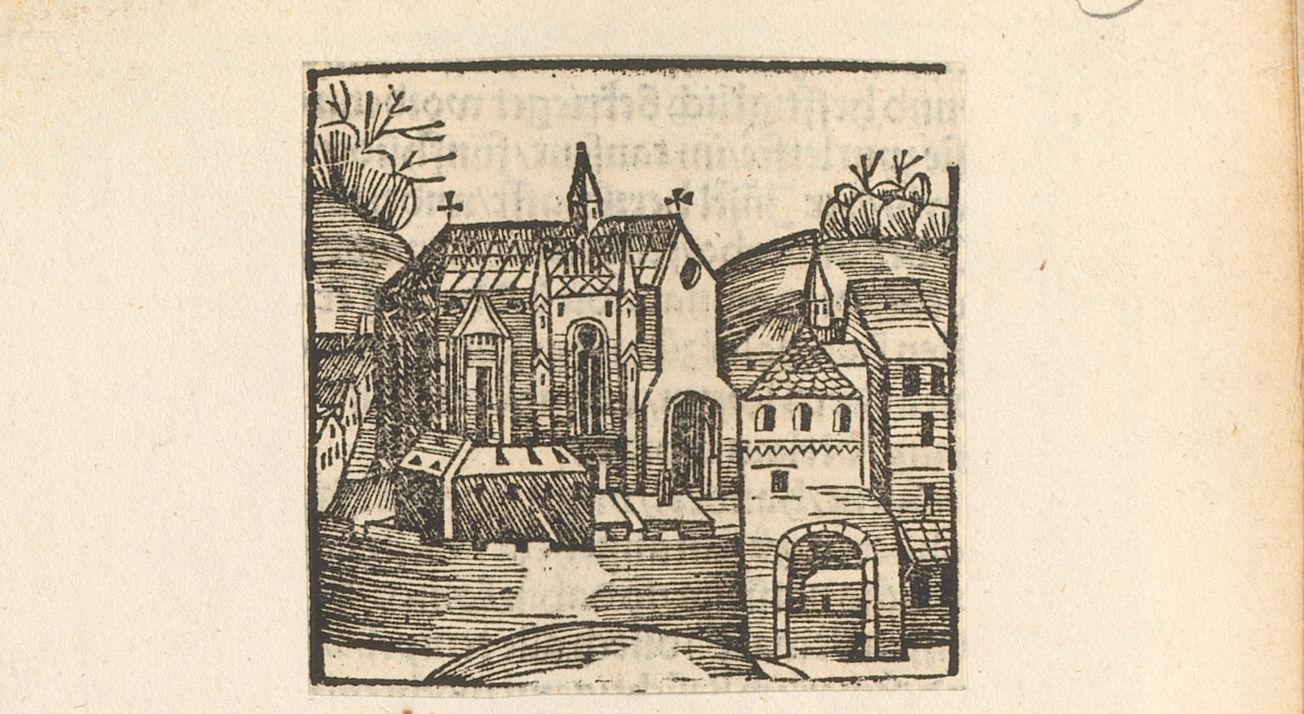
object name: album leaf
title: Stadsgezicht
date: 1490-1537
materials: paper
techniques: letterpress printing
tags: city-view in general; 'veduta'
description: Deze prent is mogelijk gebruikt in: Petrarca, Francesco. Von der Artzney bayder Glück, des guten und widerwertigen: unnd weß sich ain yeder inn Gelück und Unglück halten sol (...). Augsburg: Heinrich Steiner, 1532. Deze uitgave is ook bekend onder de titel 'Trostspiegel in Glück und Unglück'.